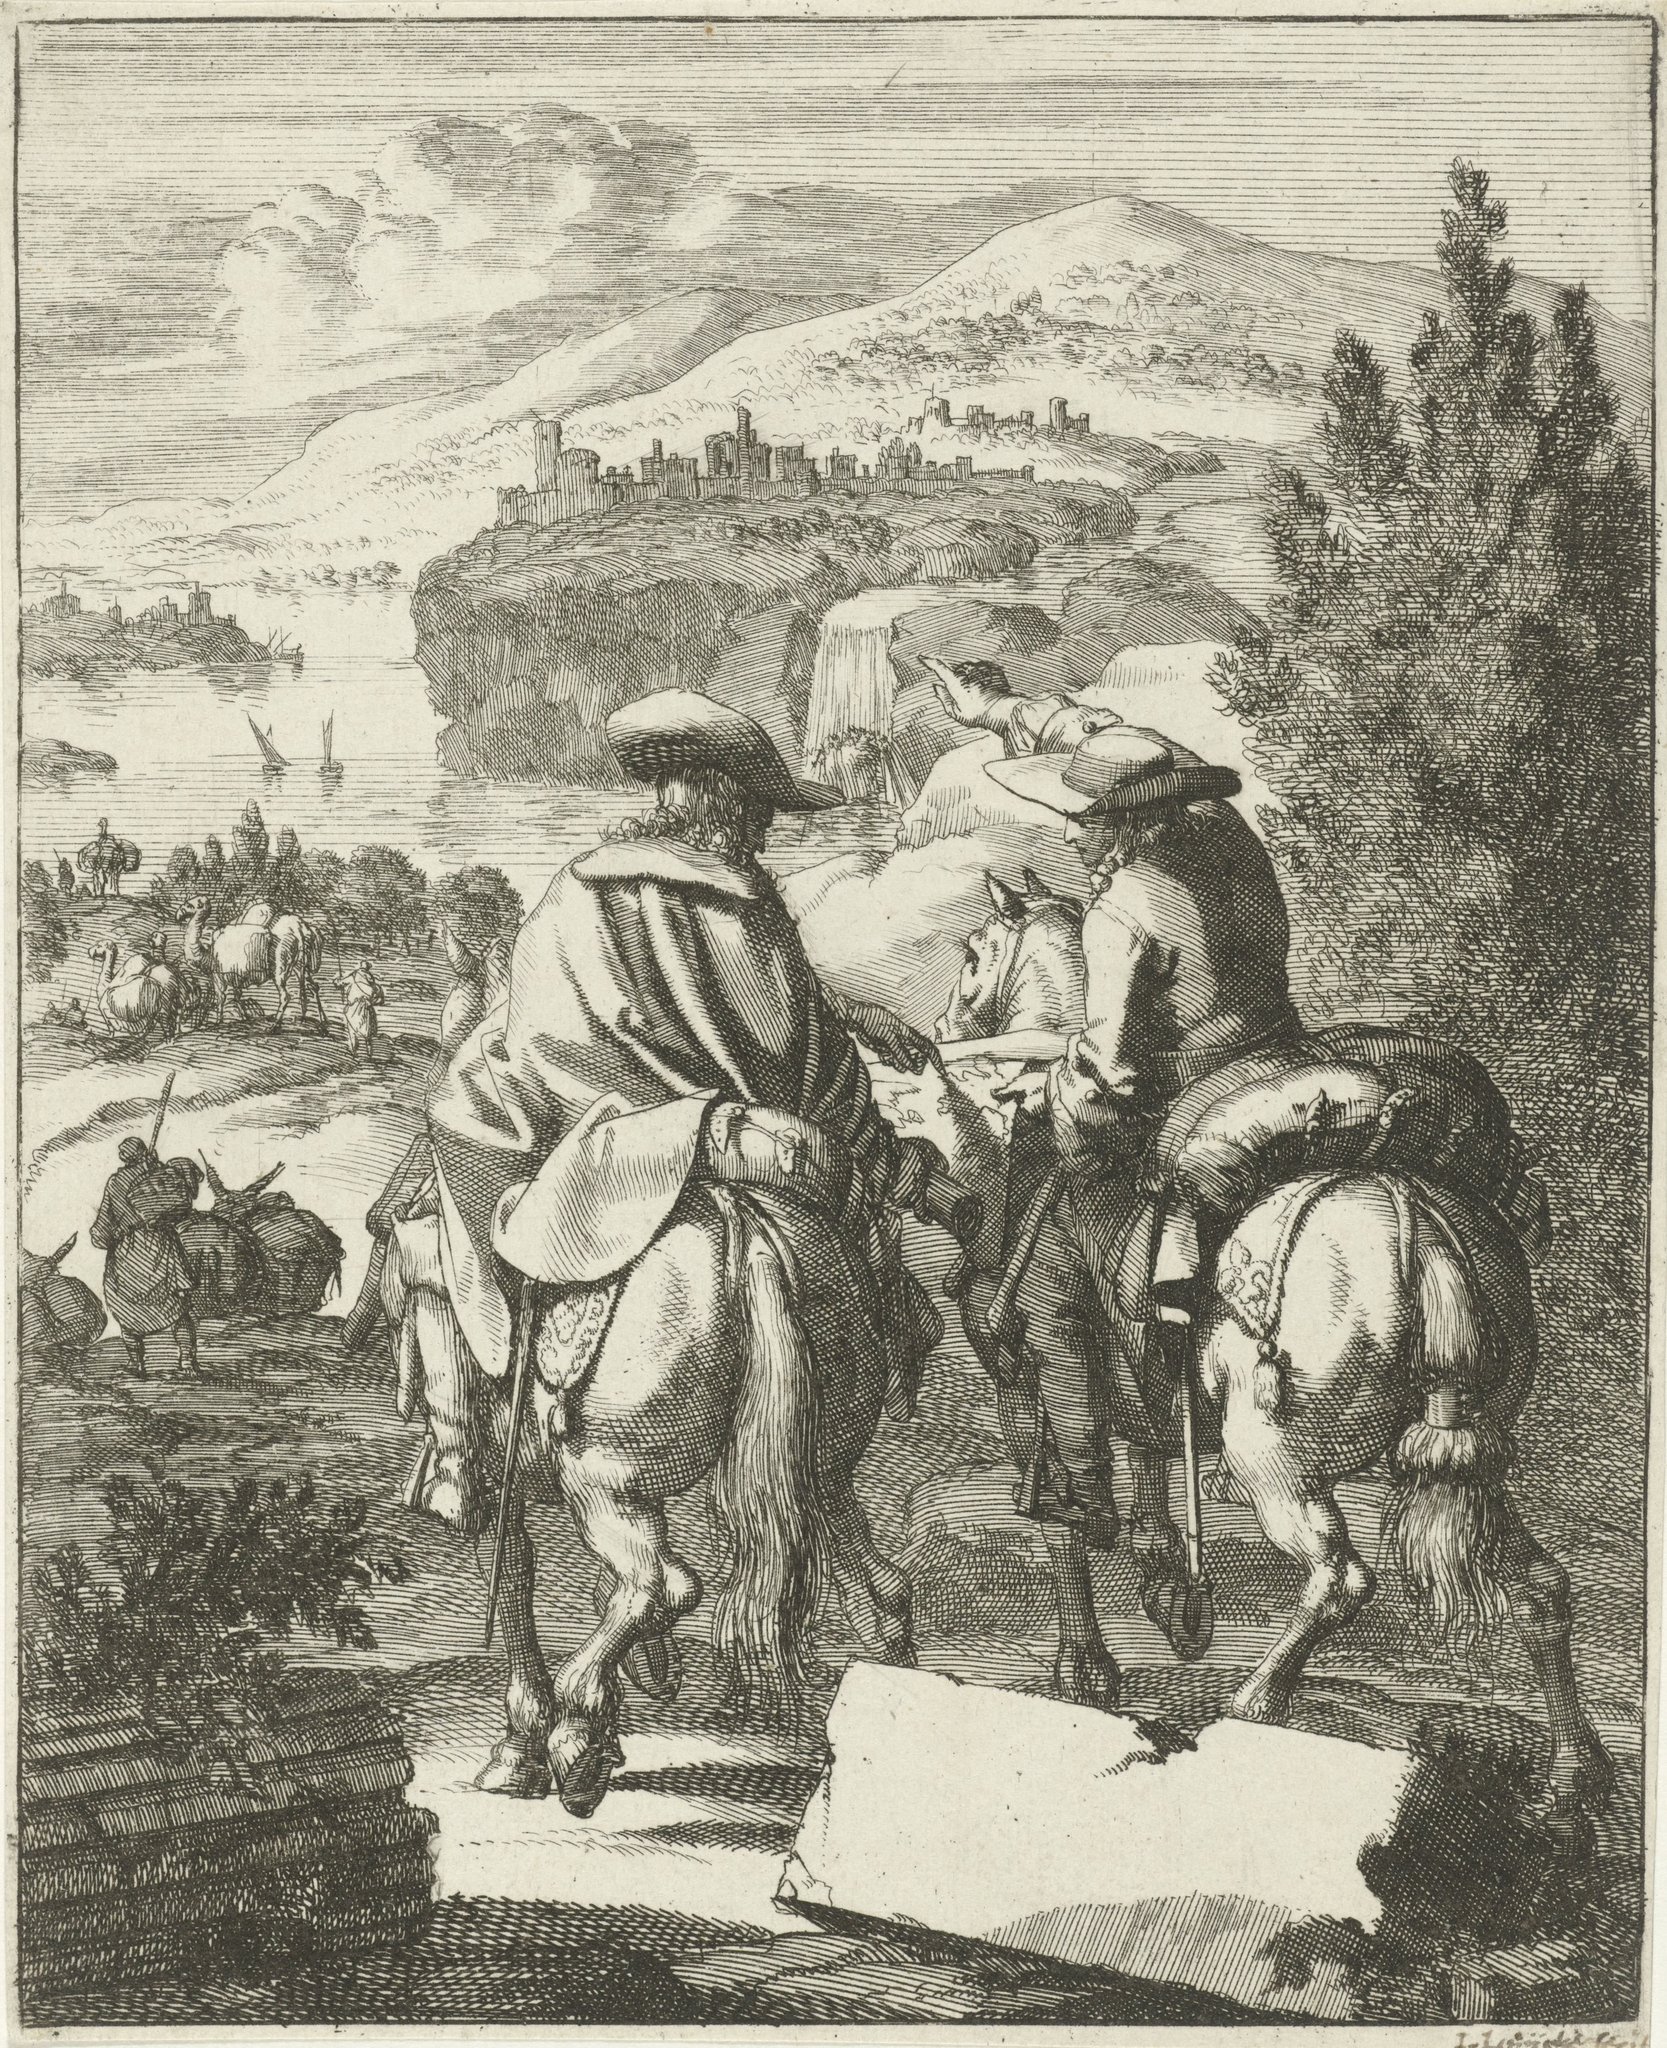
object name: print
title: Twee reizigers te paard bestuderen een kaart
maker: jan luyken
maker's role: draughtsman, print maker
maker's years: 1649-1712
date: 1689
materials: paper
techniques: etching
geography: amsterdam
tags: riding a horse, ass, or mule; rider, horseman, 'en route', traveller under way, studying a map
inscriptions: inscription: ‘I. Luyken fecit’, collector's mark: Lugt 2228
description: Proefdruk titelpagina voor: Spon, Jacob. Voyagie door Italien, Dalmatien, Grieckenland, en de Levant. Amsterdam: Jan Claesz ten Hoorn, 1689.